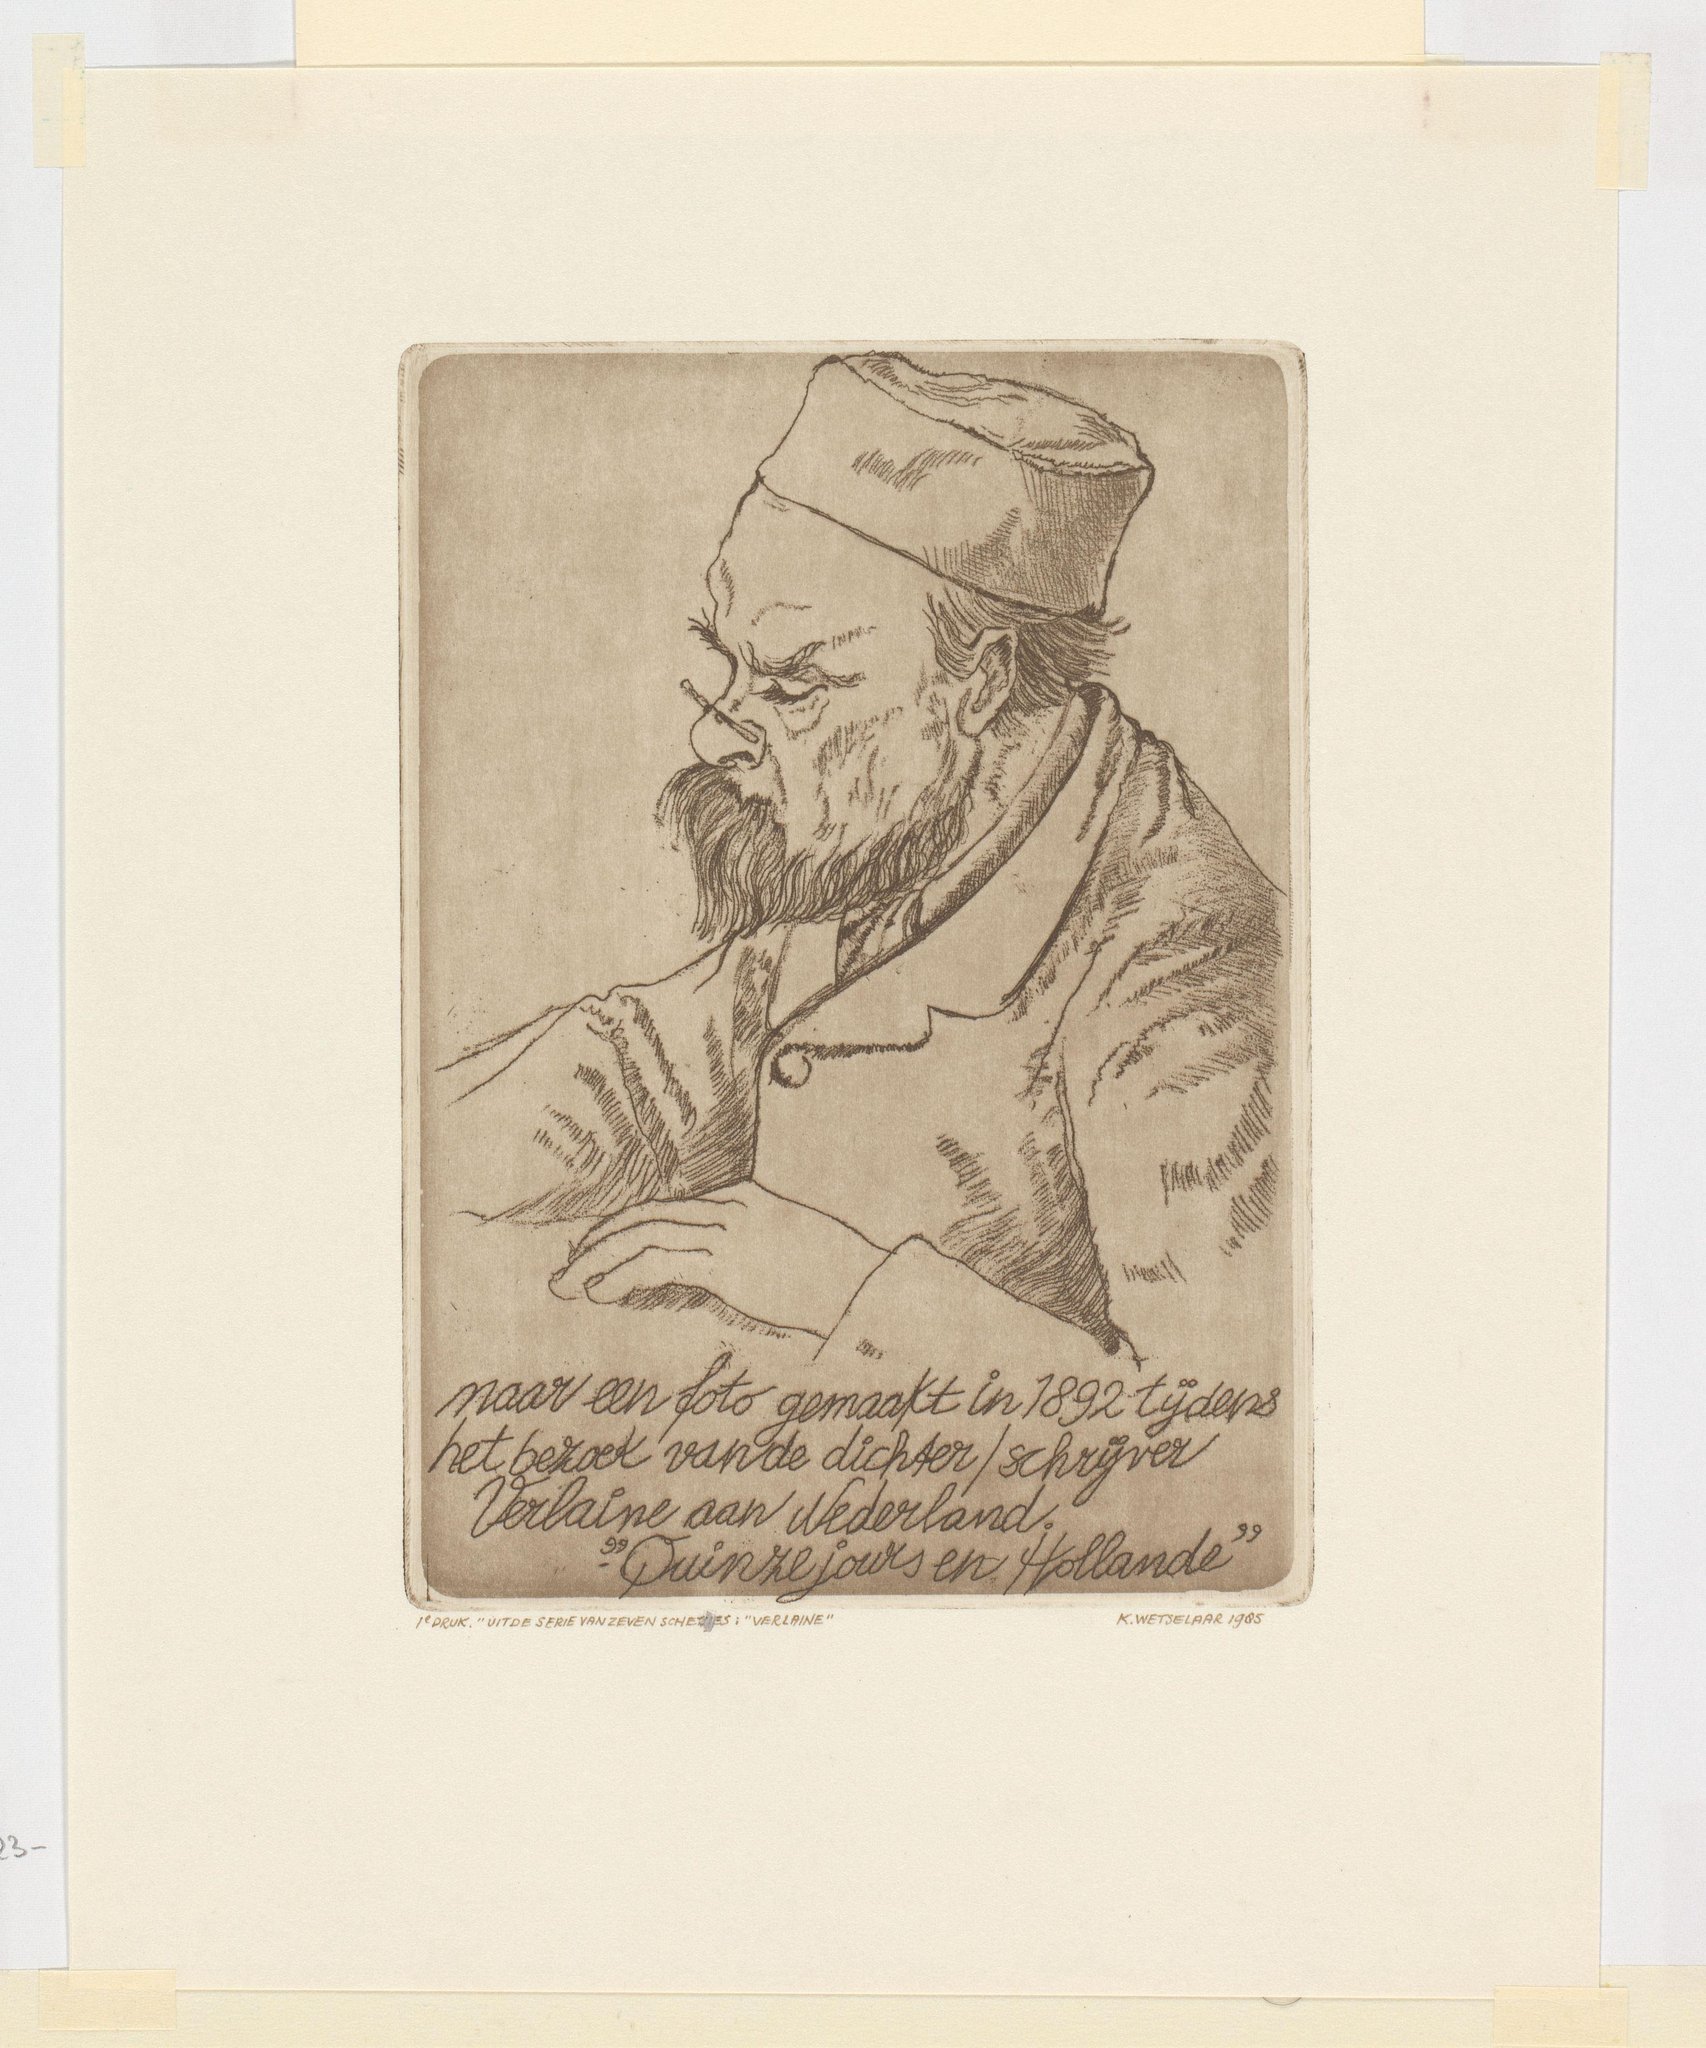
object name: print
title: Verlaine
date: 1985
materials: paper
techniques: etching, intaglio, soft ground etching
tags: paris, paul verlaine, historical persons, portrait of a writer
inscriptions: signature and date: ‘K. Wetselaar 1985’, inscription: ‘1e druk’, inscription: ‘naar een foto gemaakt in 1892 tijdens / het bezoek van de dichter/schrijver / Verlaine aan Nederland. / "Quinze jours en Hollande"’